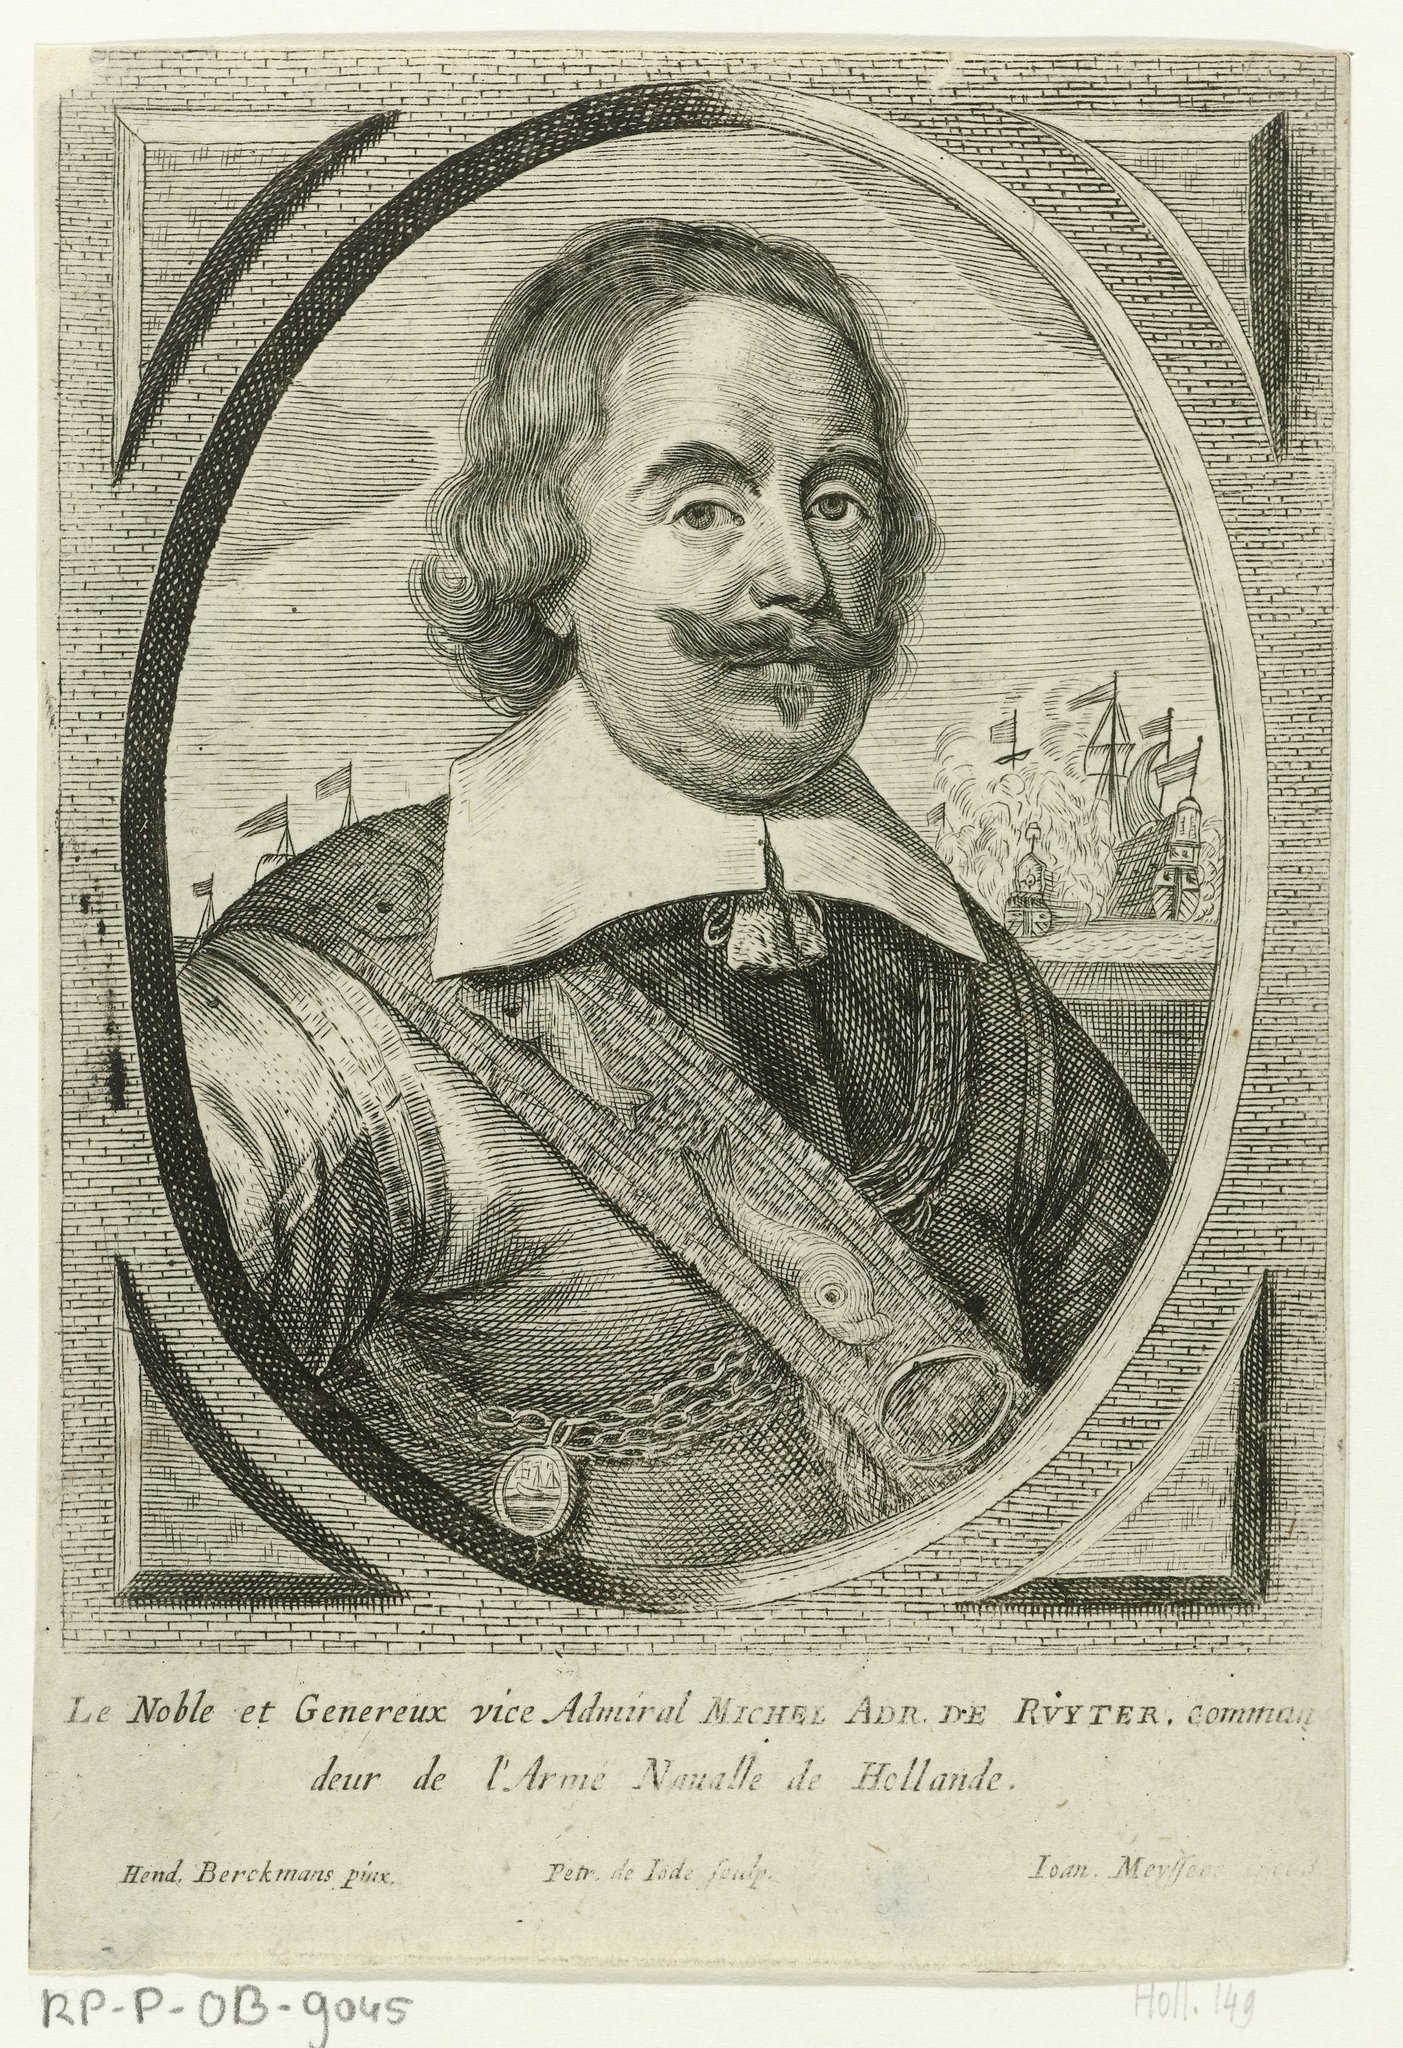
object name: print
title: Portret van admiraal Michiel Adriaenszoon de Ruyter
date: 1628-1670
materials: paper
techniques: engraving, etching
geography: antwerp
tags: michiel adriaenszoon de ruyter, battle (+ naval force), historical persons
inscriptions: collector's mark: Lugt 2228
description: Busteportret van Michiel Adriaenszoon de Ruyter. Op de achtergrond een zeeslag. Het portret is gevat in een ovale omlijsting met vierkant randwerk. In de marge een tweeregelig onderschrift in het Frans.